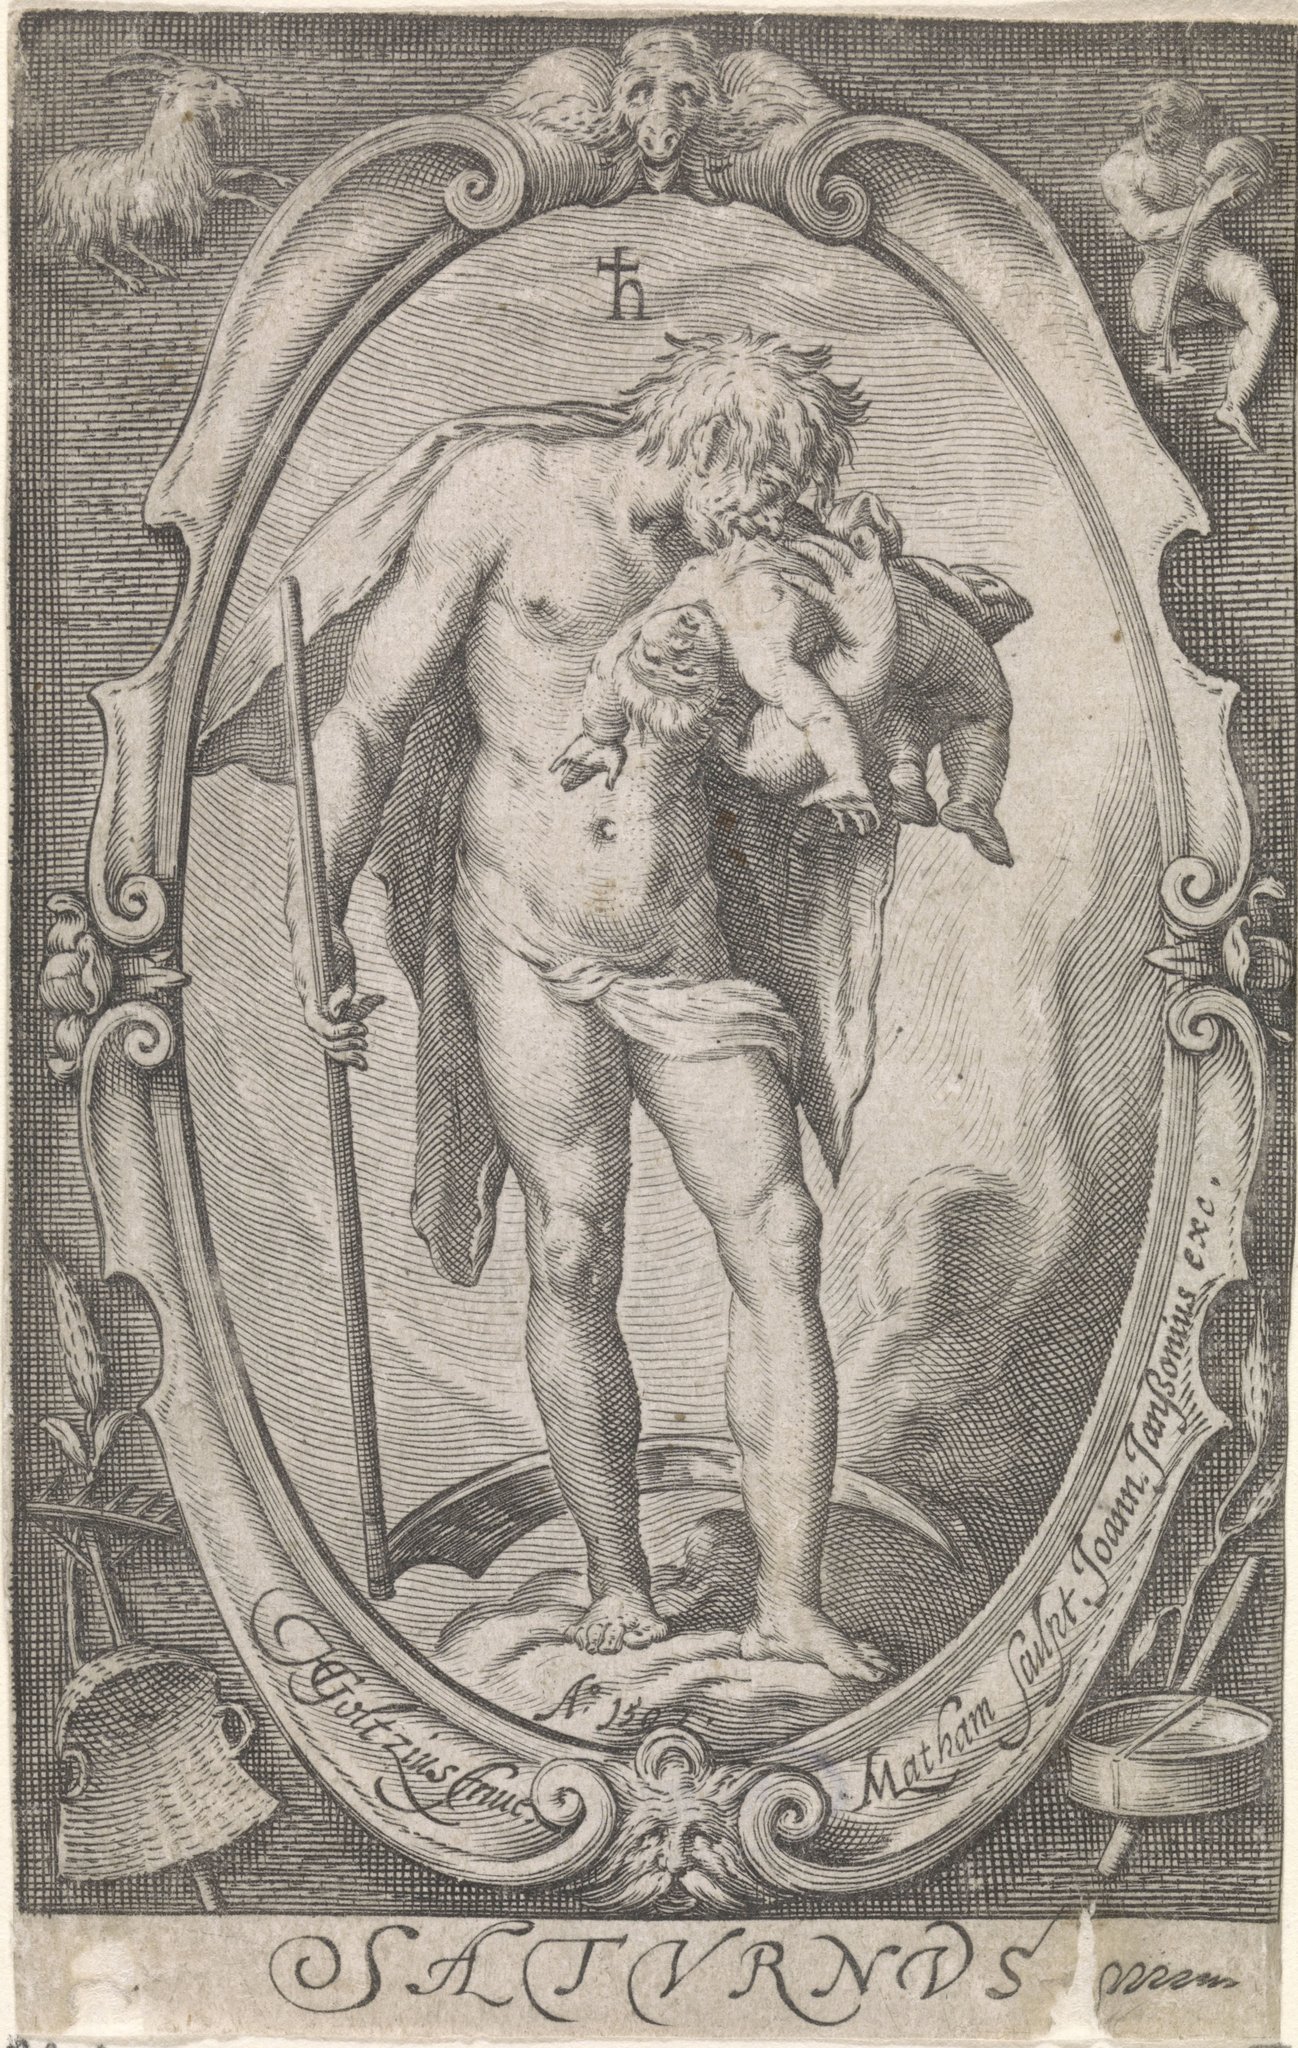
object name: print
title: Satvrnvs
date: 1597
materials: paper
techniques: engraving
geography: amsterdam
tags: saturn and his children ('planetenkinder')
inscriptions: collector's mark: Lugt 2228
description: Saturnus die zijn kind verzwelgt, in zijn hand een zeis en boven zijn hoofd het astronomische symbool voor zijn planeet. Staand in een ovaal cartouche met bovenaan de twee tekenen van de dierenriem: Steenbok en Waterman.